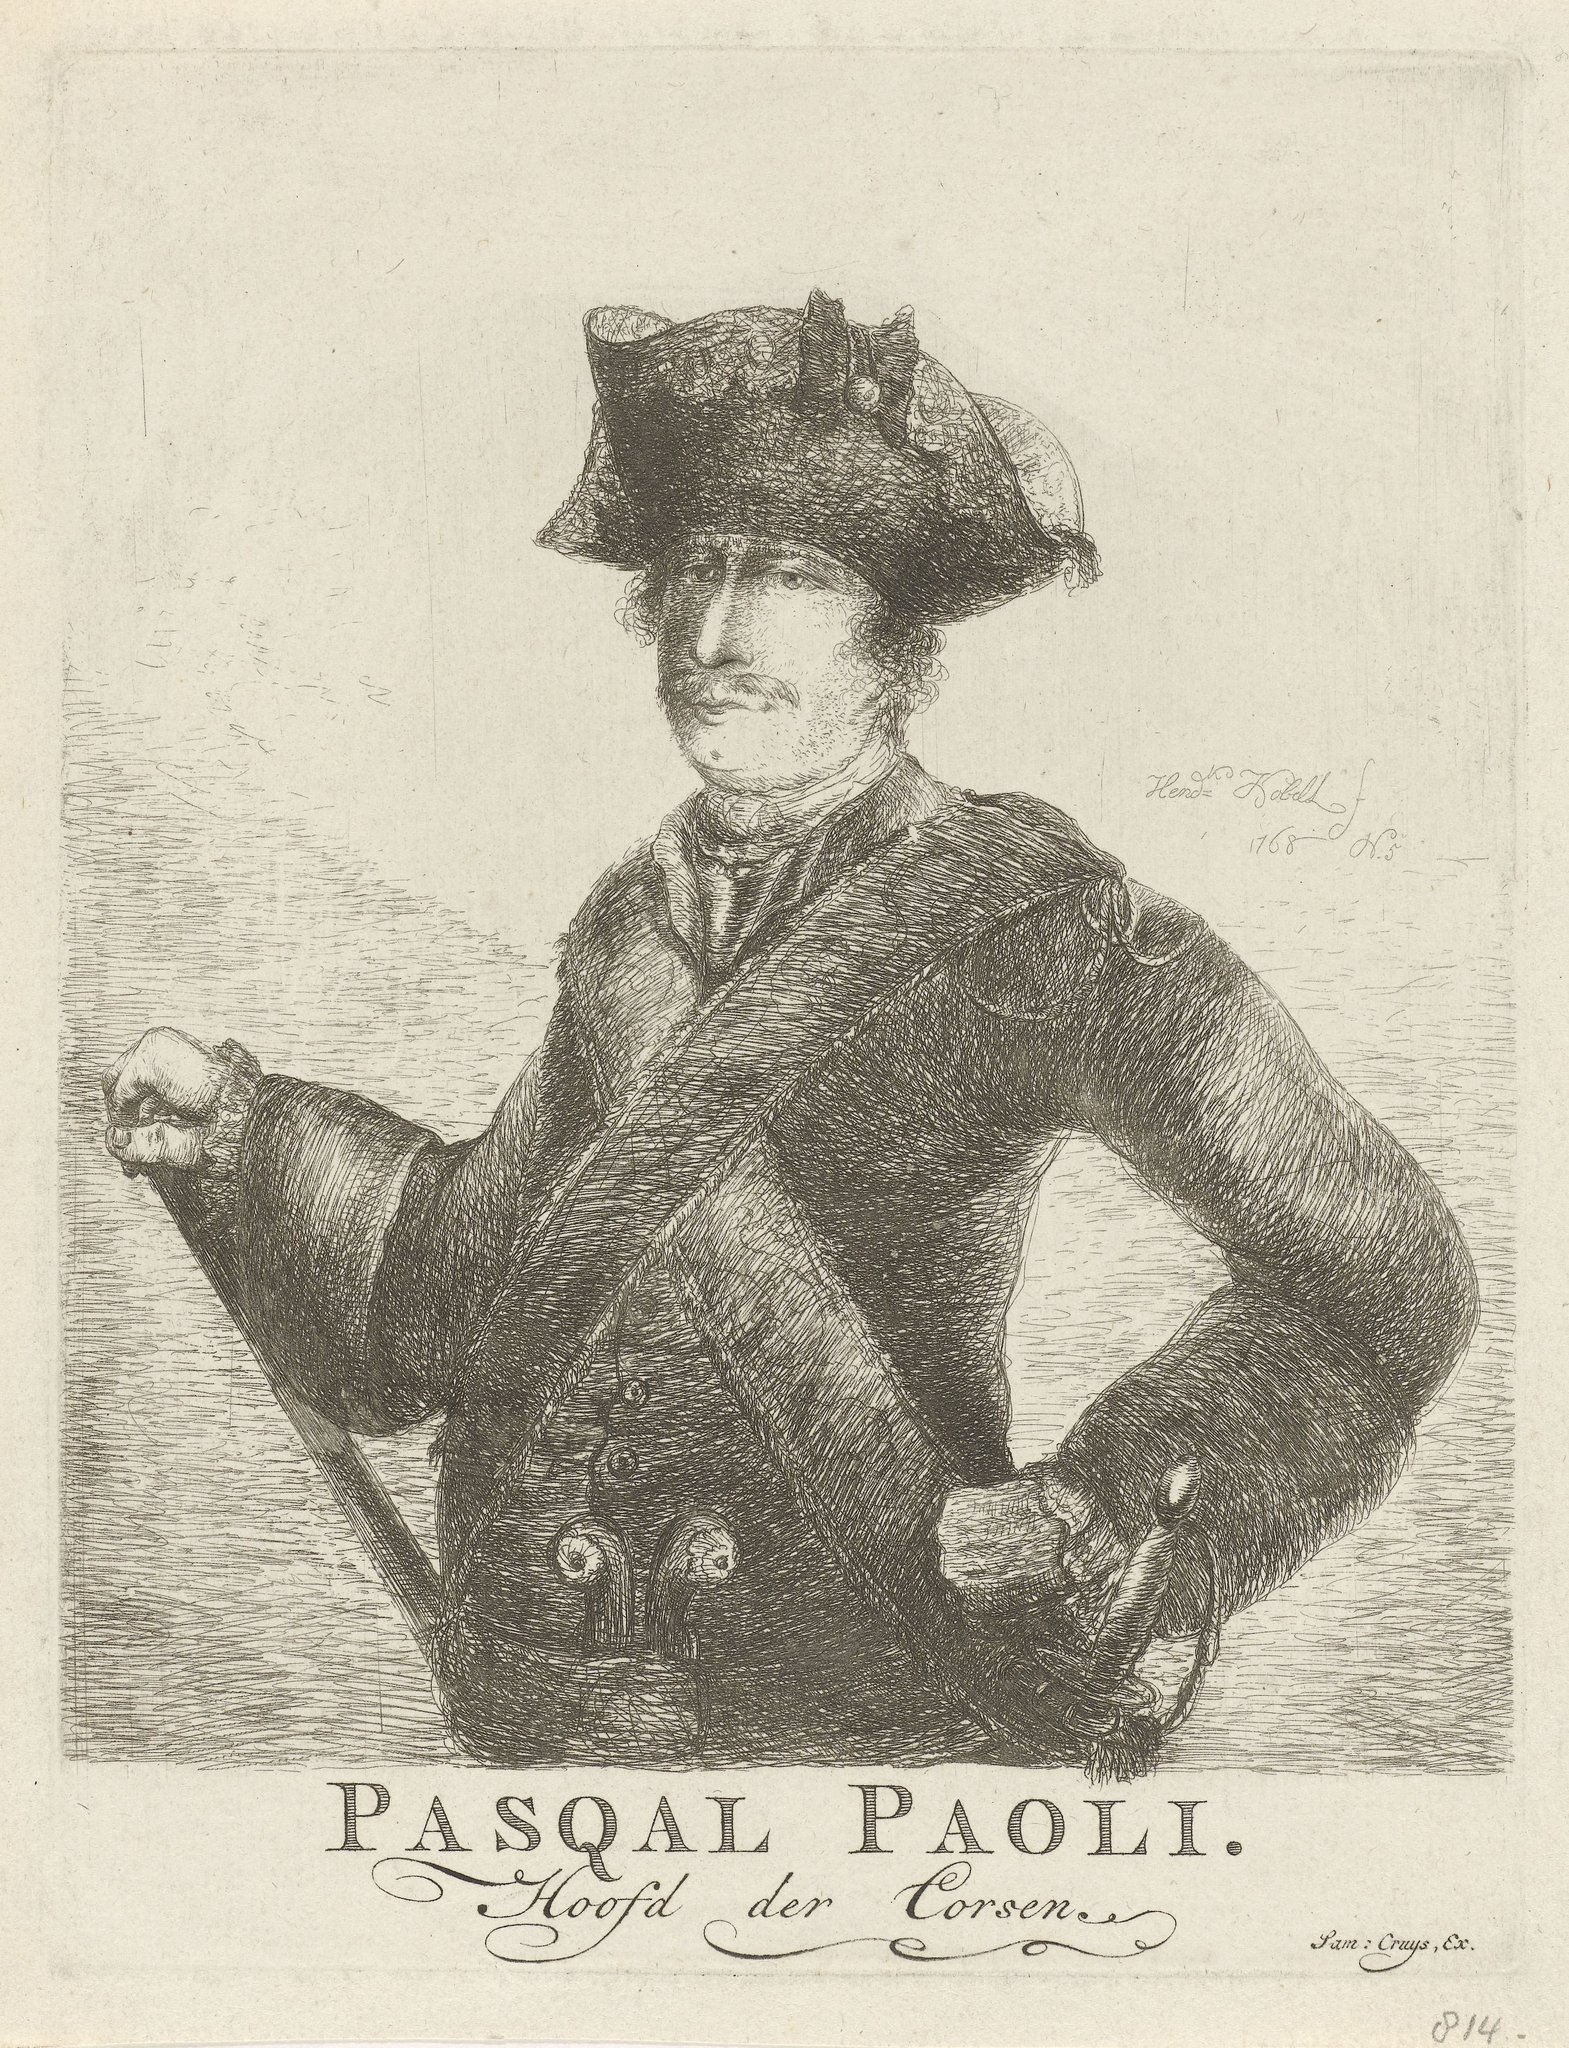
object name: print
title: Pasqual Paoli Hoofd der Corsen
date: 1768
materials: paper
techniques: etching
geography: rotterdam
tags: london, historical persons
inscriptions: collector's mark: Lugt 2228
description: Portret van Pascal Paoli, generaal en leider van de Corsicanen. Hij draagt een uniform met bijpassende punthoed en heeft in zijn rechterhand een staf.